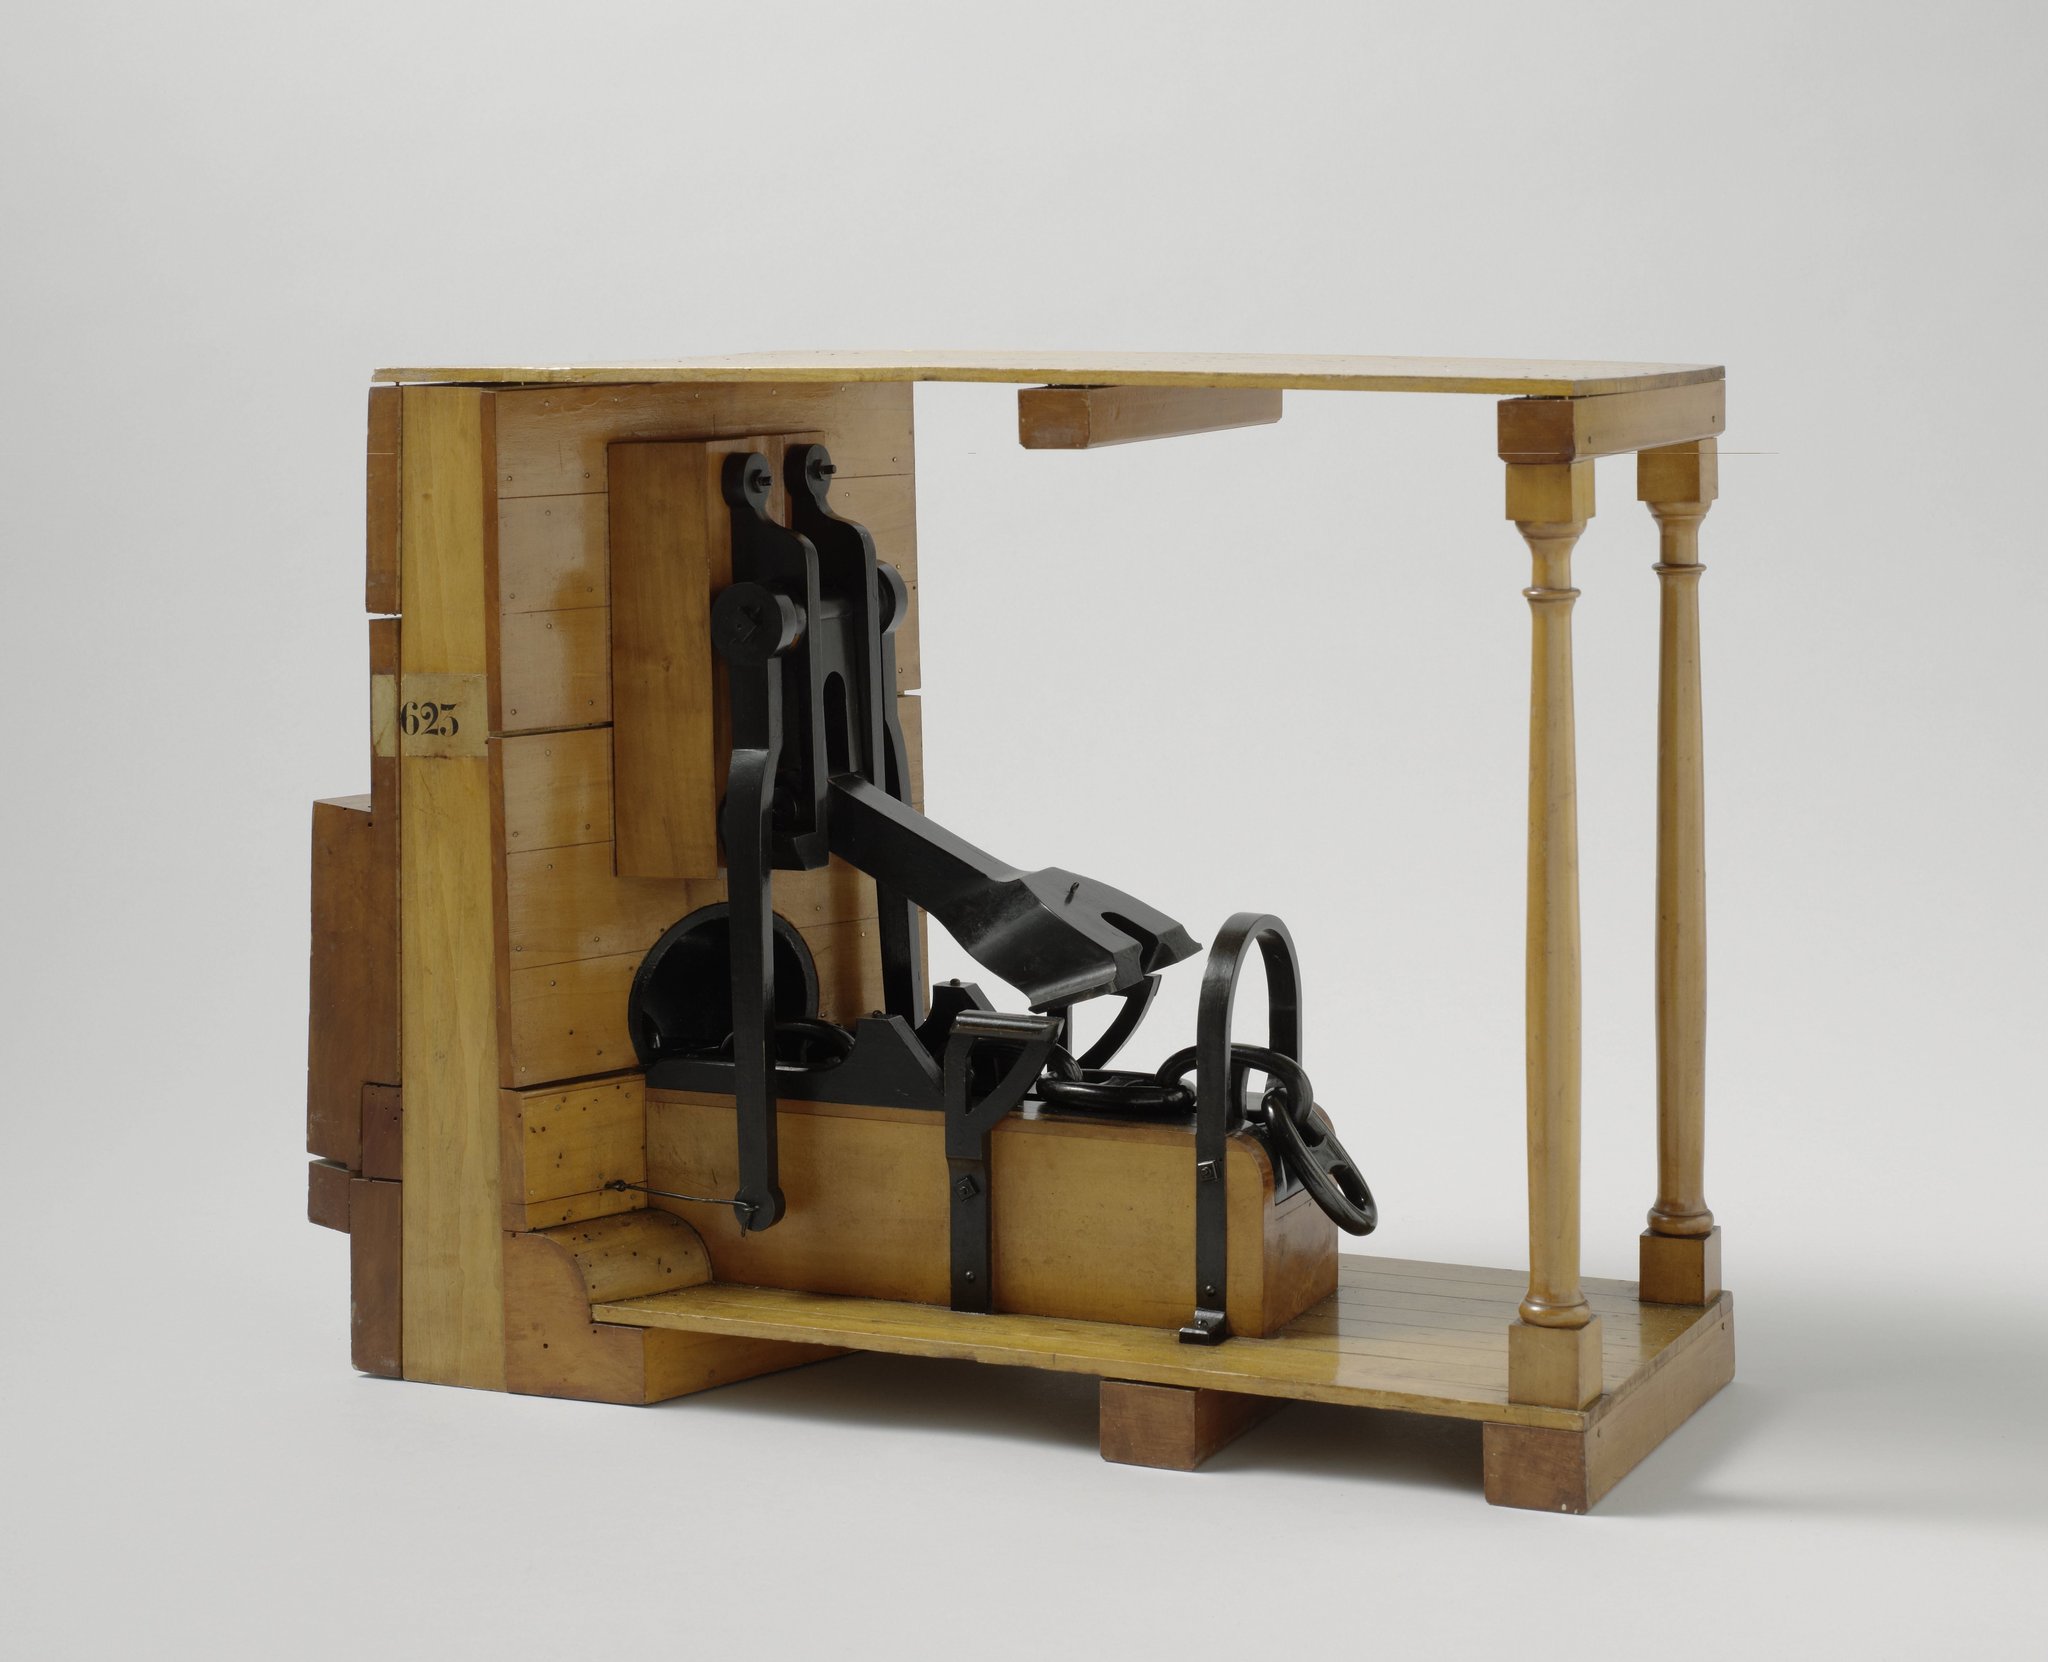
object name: demonstration model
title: Model of a Stopper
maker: w.f. momma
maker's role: constructeur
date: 1840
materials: brass, wood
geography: netherlands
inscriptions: label: ‘623’ former inventory label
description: Model van een ankerstopper tussen twee dekken, bestaande uit een glijbaan voor de ketting op een klos en doorlopend door het stuurboord kluisgat, en een zware duivelsklauw hangend aan een klos aan de scheepswand. Een opsluitmechanisme houdt de as van de klauw op zijn plaats, maar kan geopend worden met twee hefbomen aan de zijkanten; de klauw schuift dan naar boven waardoor de ketting vrijkomt. Een houten ketting is aan het model toegevoegd. Schaal 1:5 (schatting).